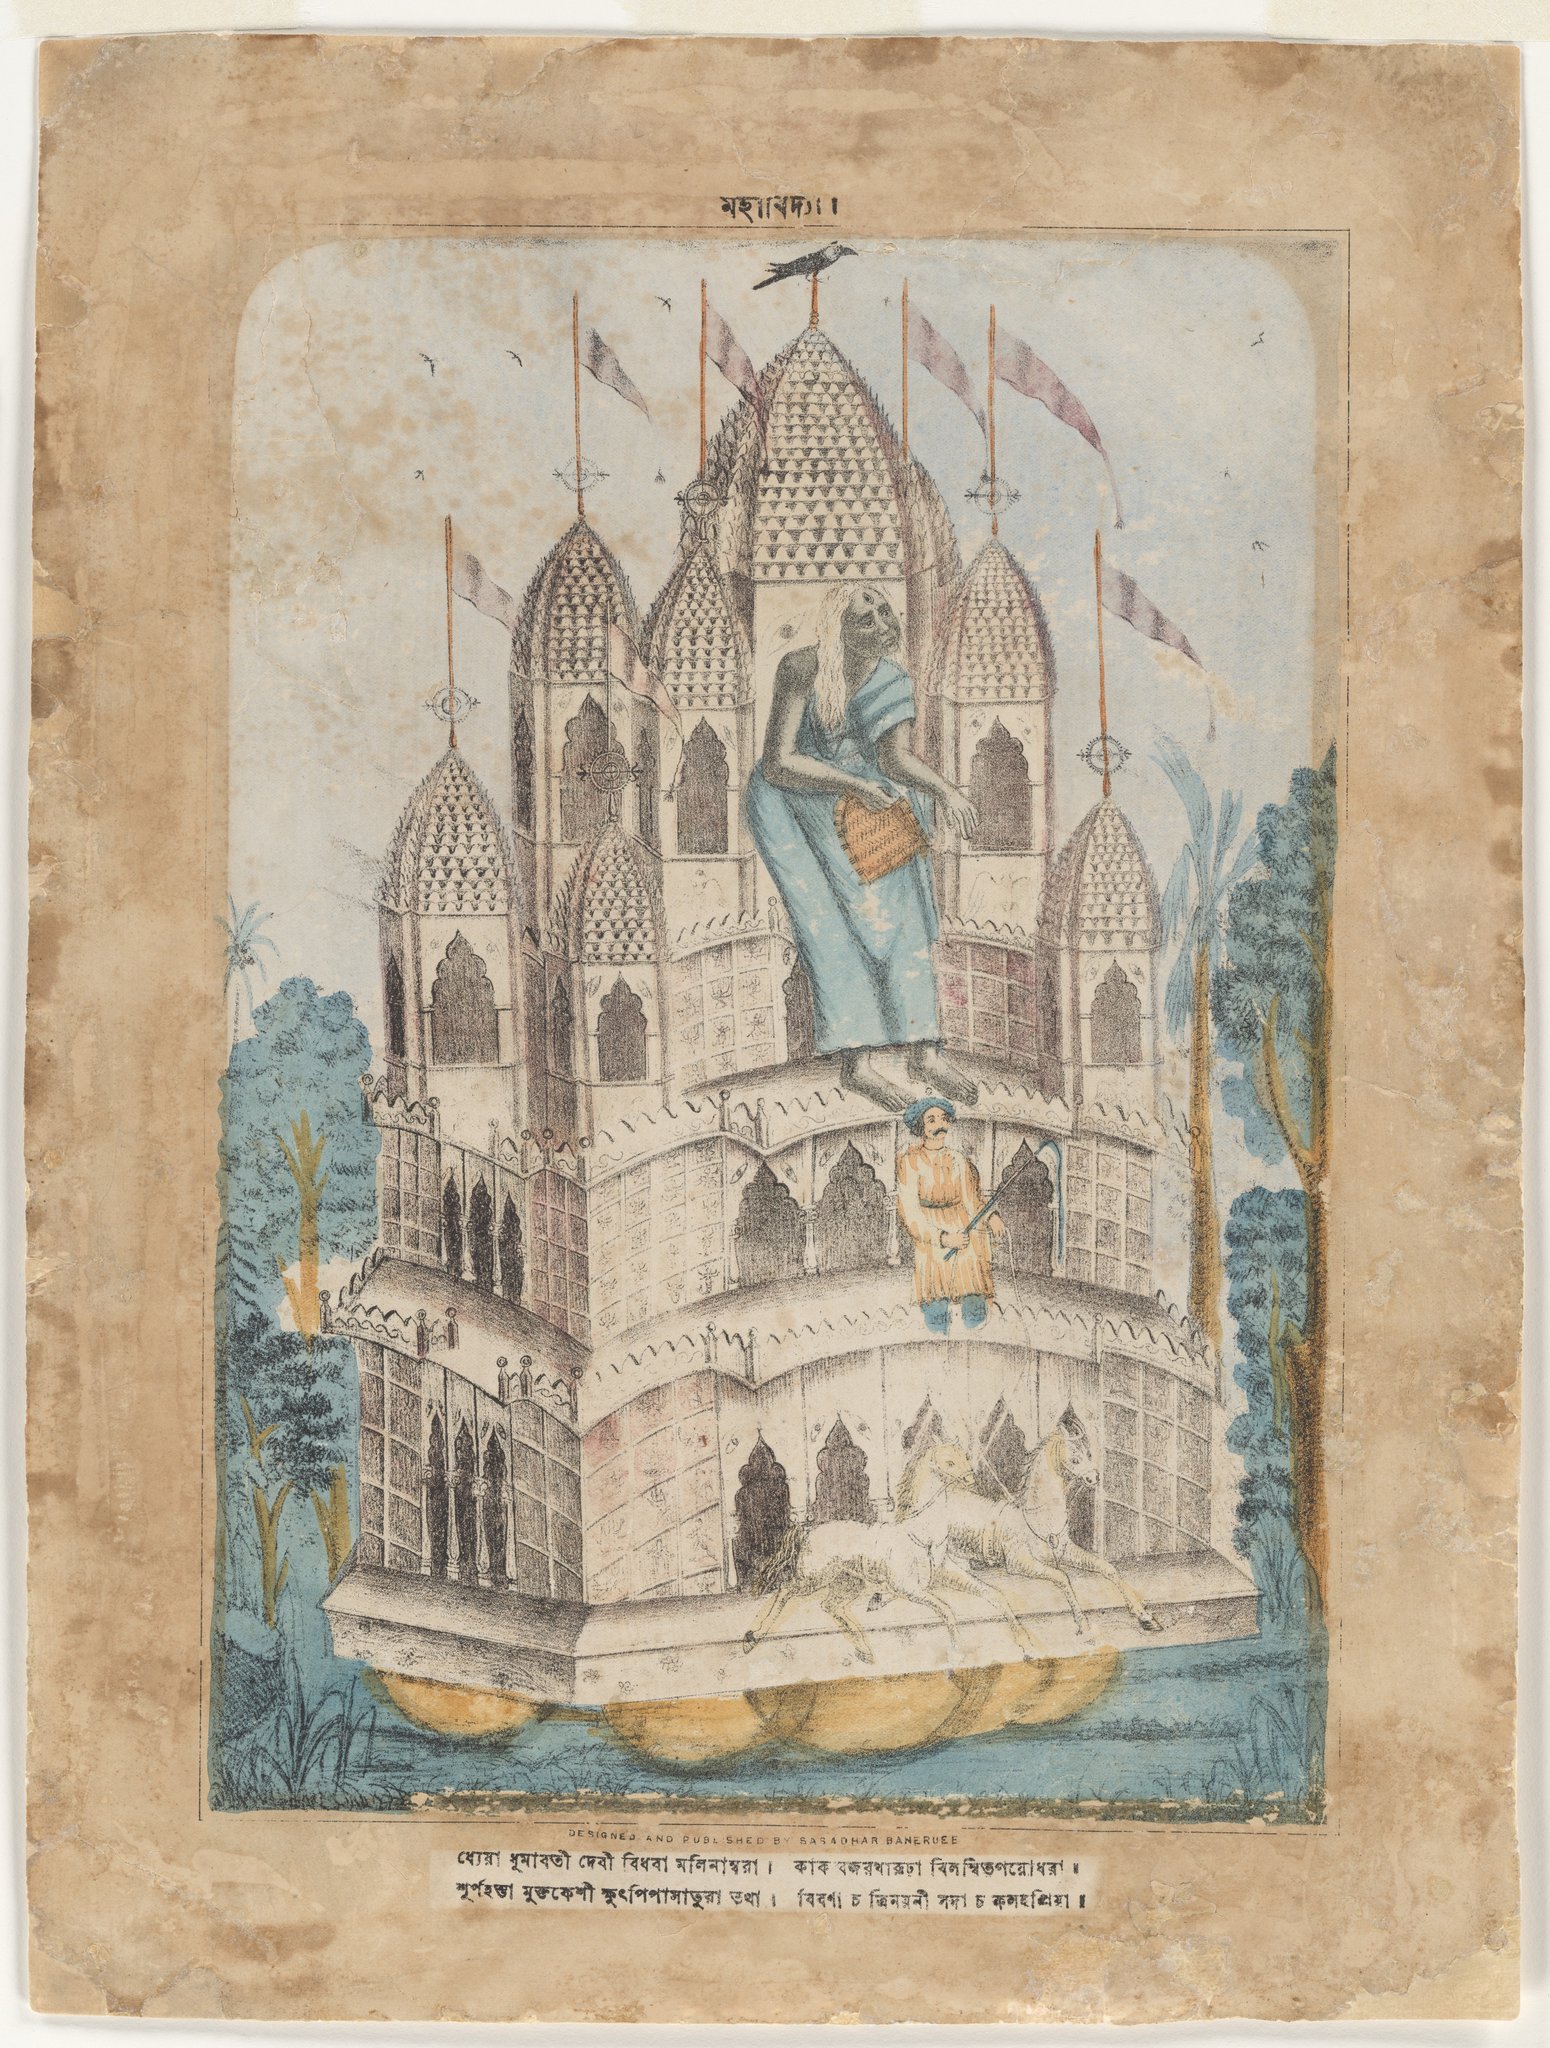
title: Goddess Dhumavati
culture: west bengali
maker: sasadhar banarjee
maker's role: artist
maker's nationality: indian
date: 1875-1885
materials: glaze, watercolor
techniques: hand coloring, lithograph, printing